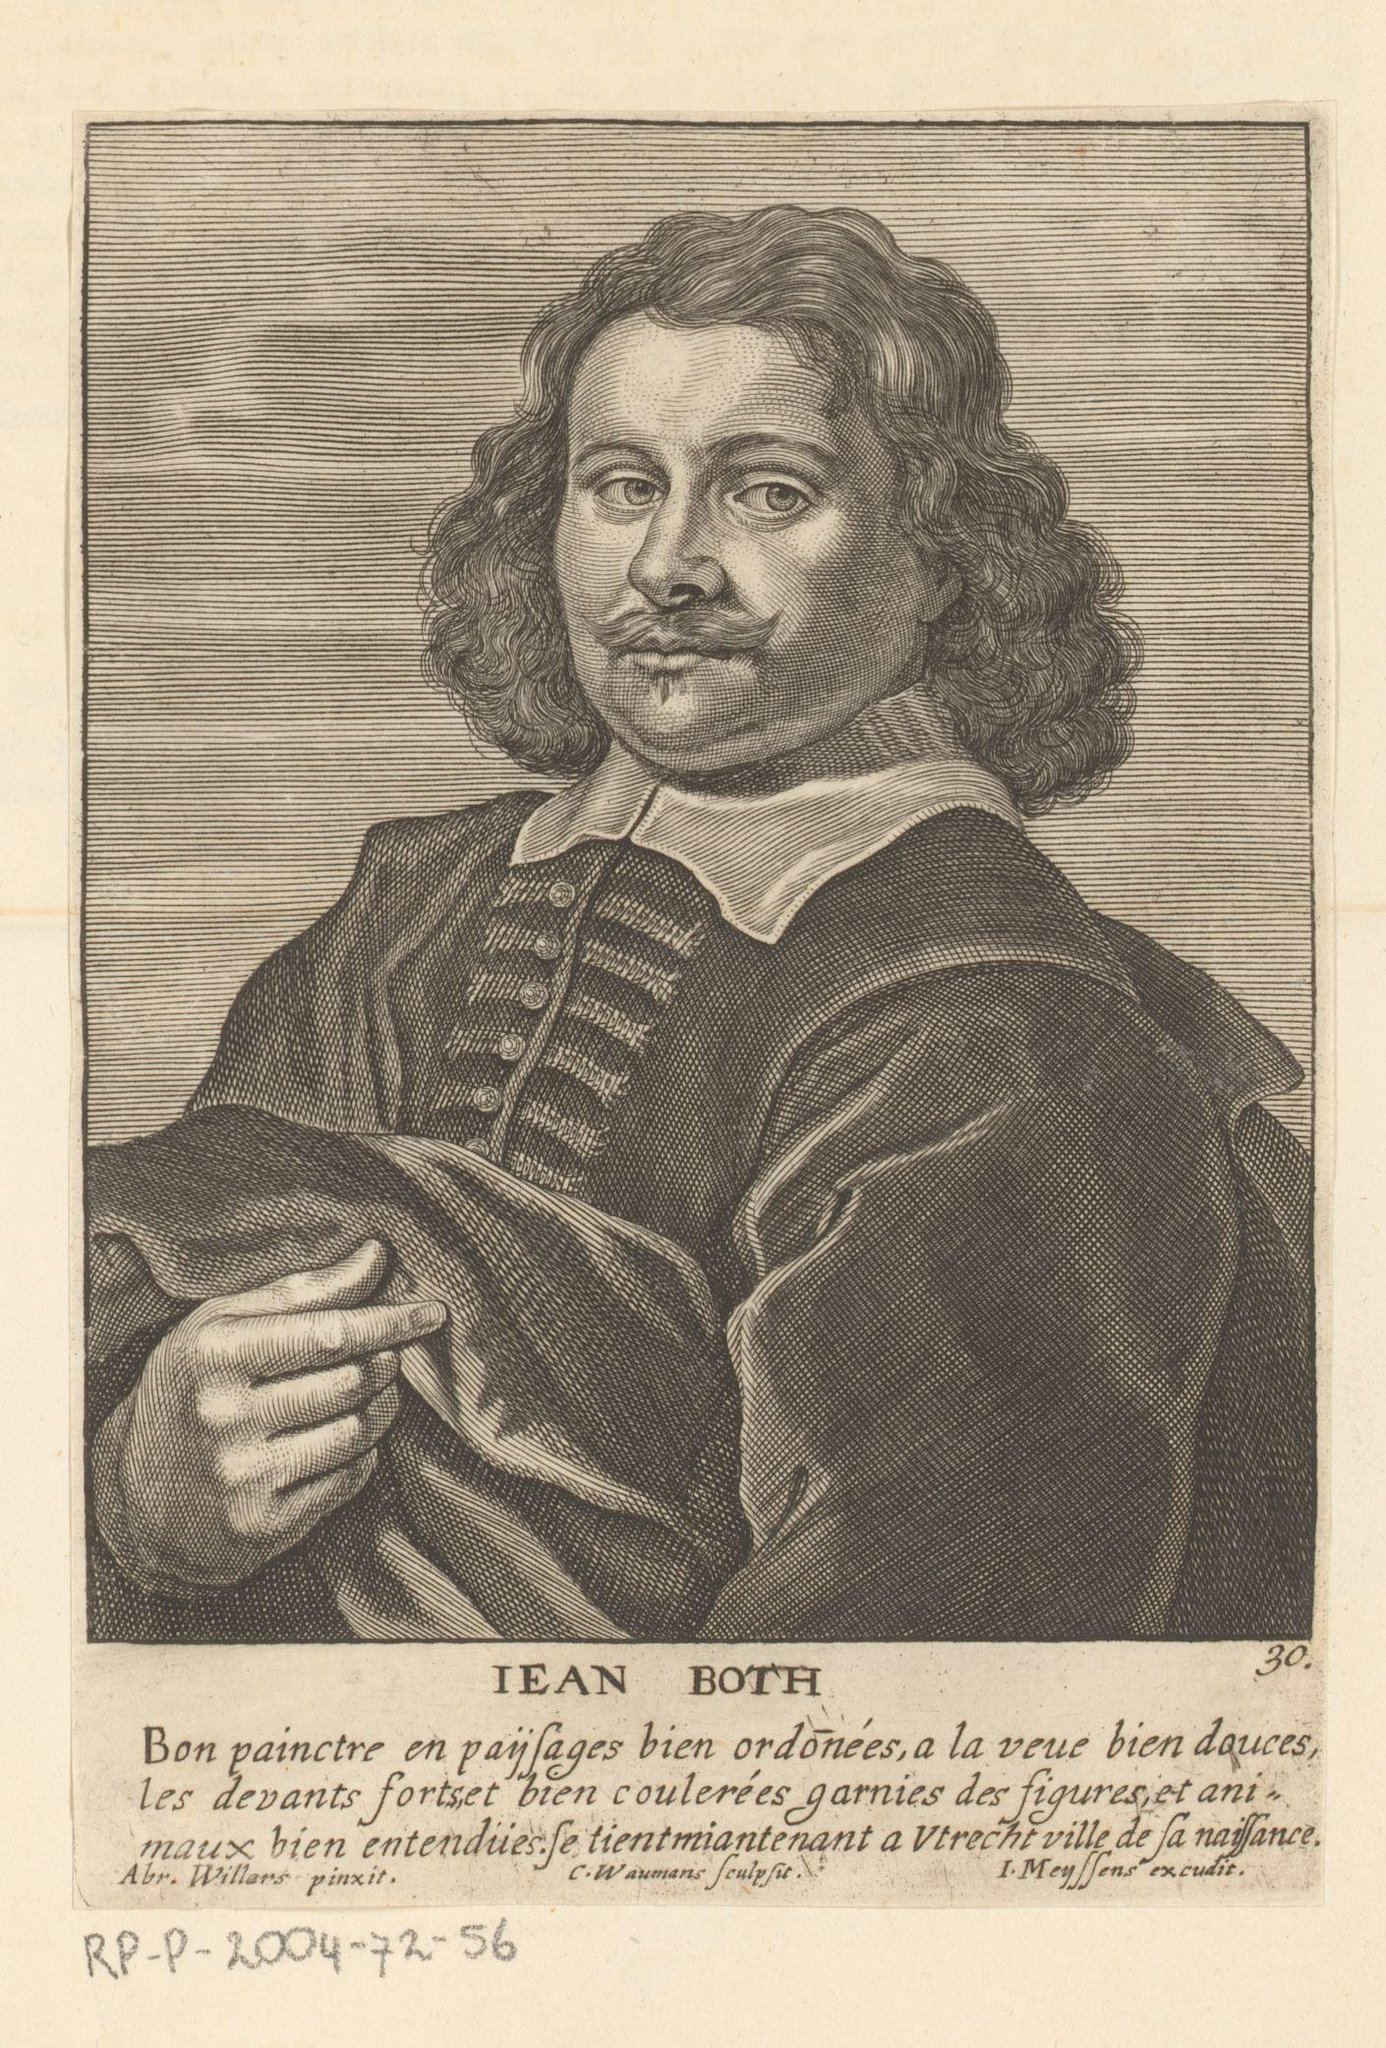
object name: book illustration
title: Iean Both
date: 1649-1662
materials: paper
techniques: engraving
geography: antwerp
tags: utrecht, painter, print maker, draughtsman, jan both, historical persons, portrait, self-portrait of painter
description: Prent mogelijk uit: Meyssens, Joannes. Image de divers hommes desprit sublime qui par leur art et science deburovent vivre eternellement et des quels la louange et renommée faict estonner le monde. Antwerpen: Joannes Meyssens, 1649, dl. 1, p. 5. Andere staat van prent gebruikt in: Bie, Cornelis De. Het gulden Cabinet vande edel vry schilder const, inhoudende den lof vande vermarste schilders, architecte, beldthowers ende plaetsnyders van dese eeuw. Antwerpen: Joannes Meyssens, 1662 [1661 foutief op titelpagina], p. 157. De samensteller heeft deze prent in het album geplakt als illustratie bij: Pilkington, Matthew en Johann Heinrich Füssli. A dictionary of painters, from the revival of the art to the present period. 4 dln. Londen: John Crowder, 1805, dl. 1, p. 72.